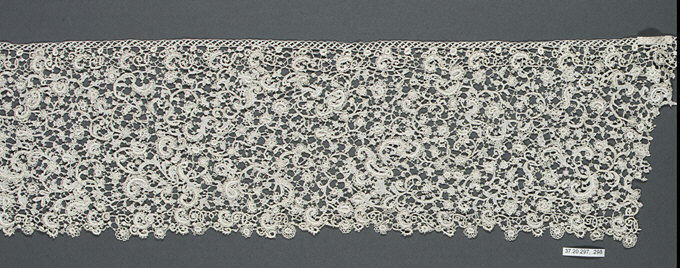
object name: border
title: Border (one of two joined)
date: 1701-1733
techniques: lace